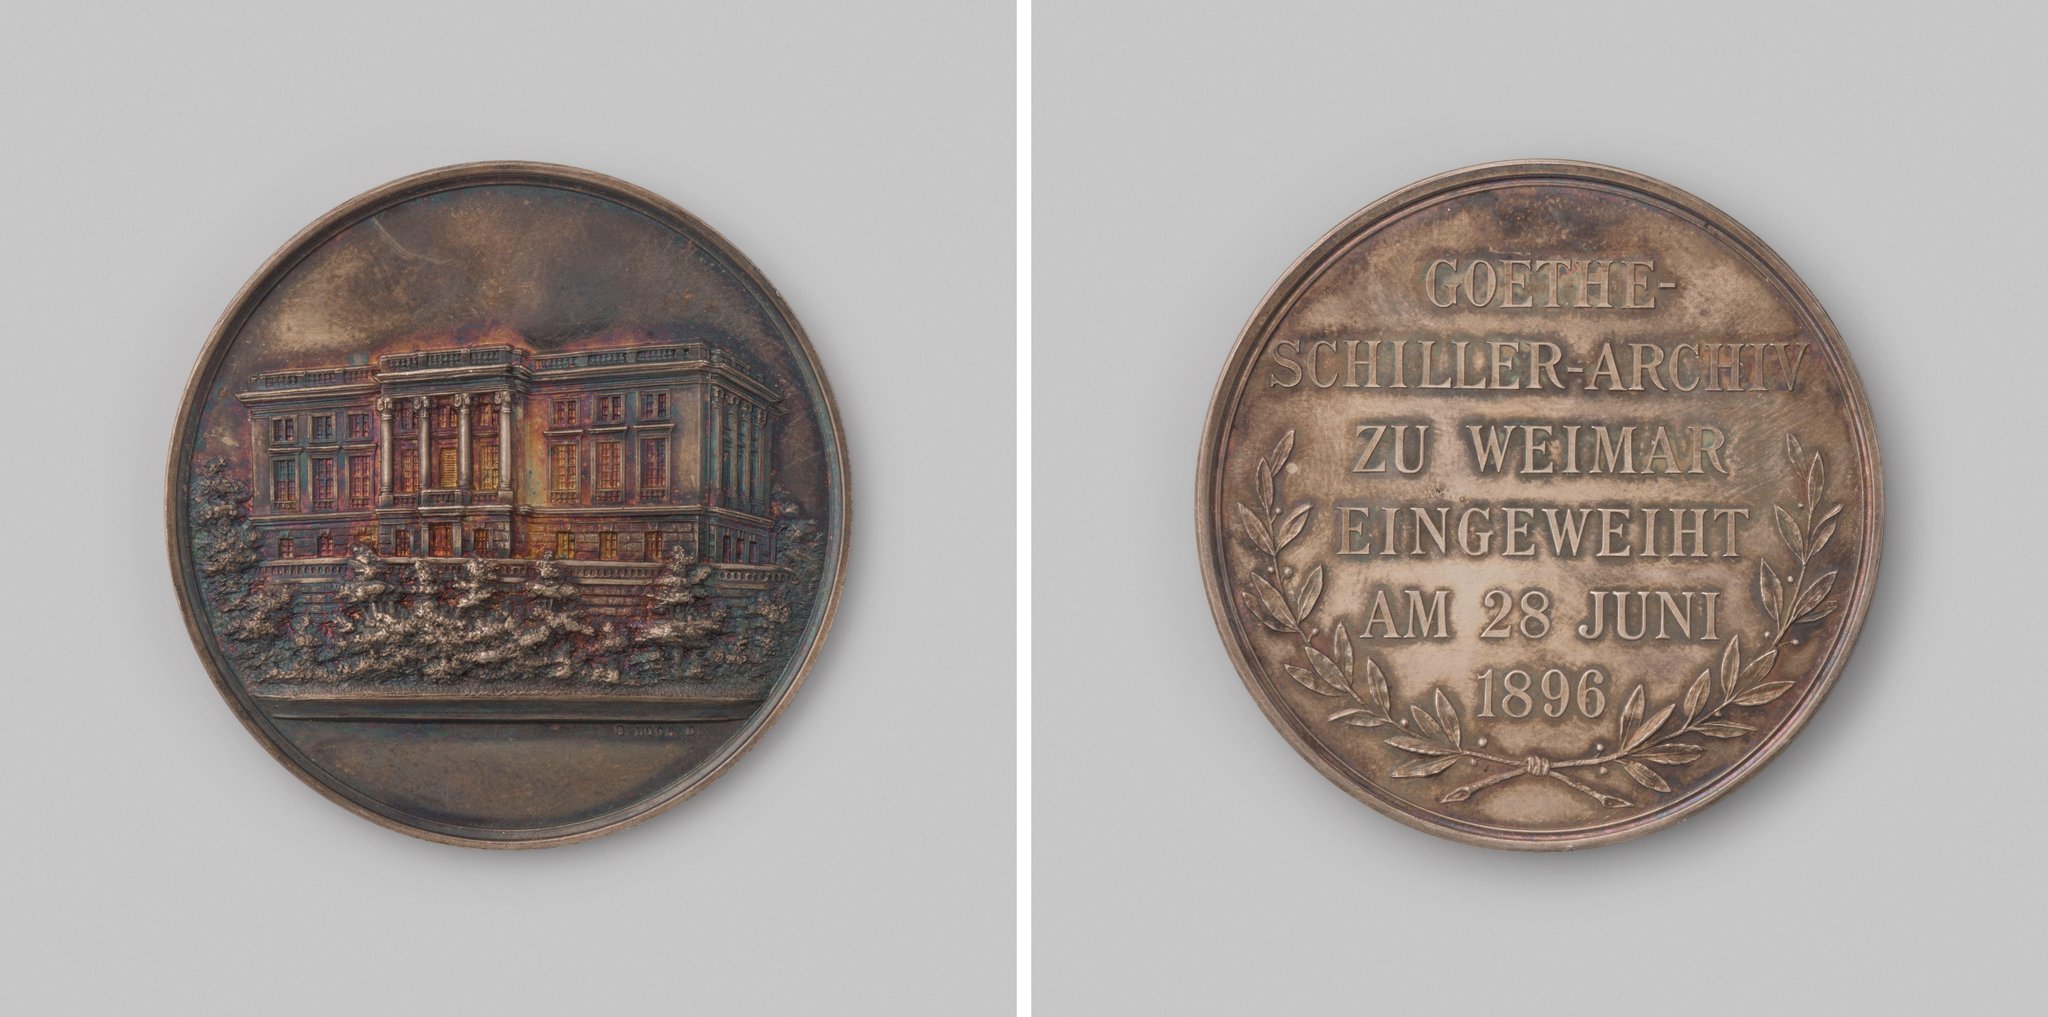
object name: history medal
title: Opening van het Goethe Schiller Archief te Weimar 1896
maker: g. loos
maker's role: designer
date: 1896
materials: silver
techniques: striking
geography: berlin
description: Zilveren penning, op de voorzijde het aanzicht van het archiefgebouw bijna van voren, op de keerzijde zes regels tekst tussen lauwertakken.